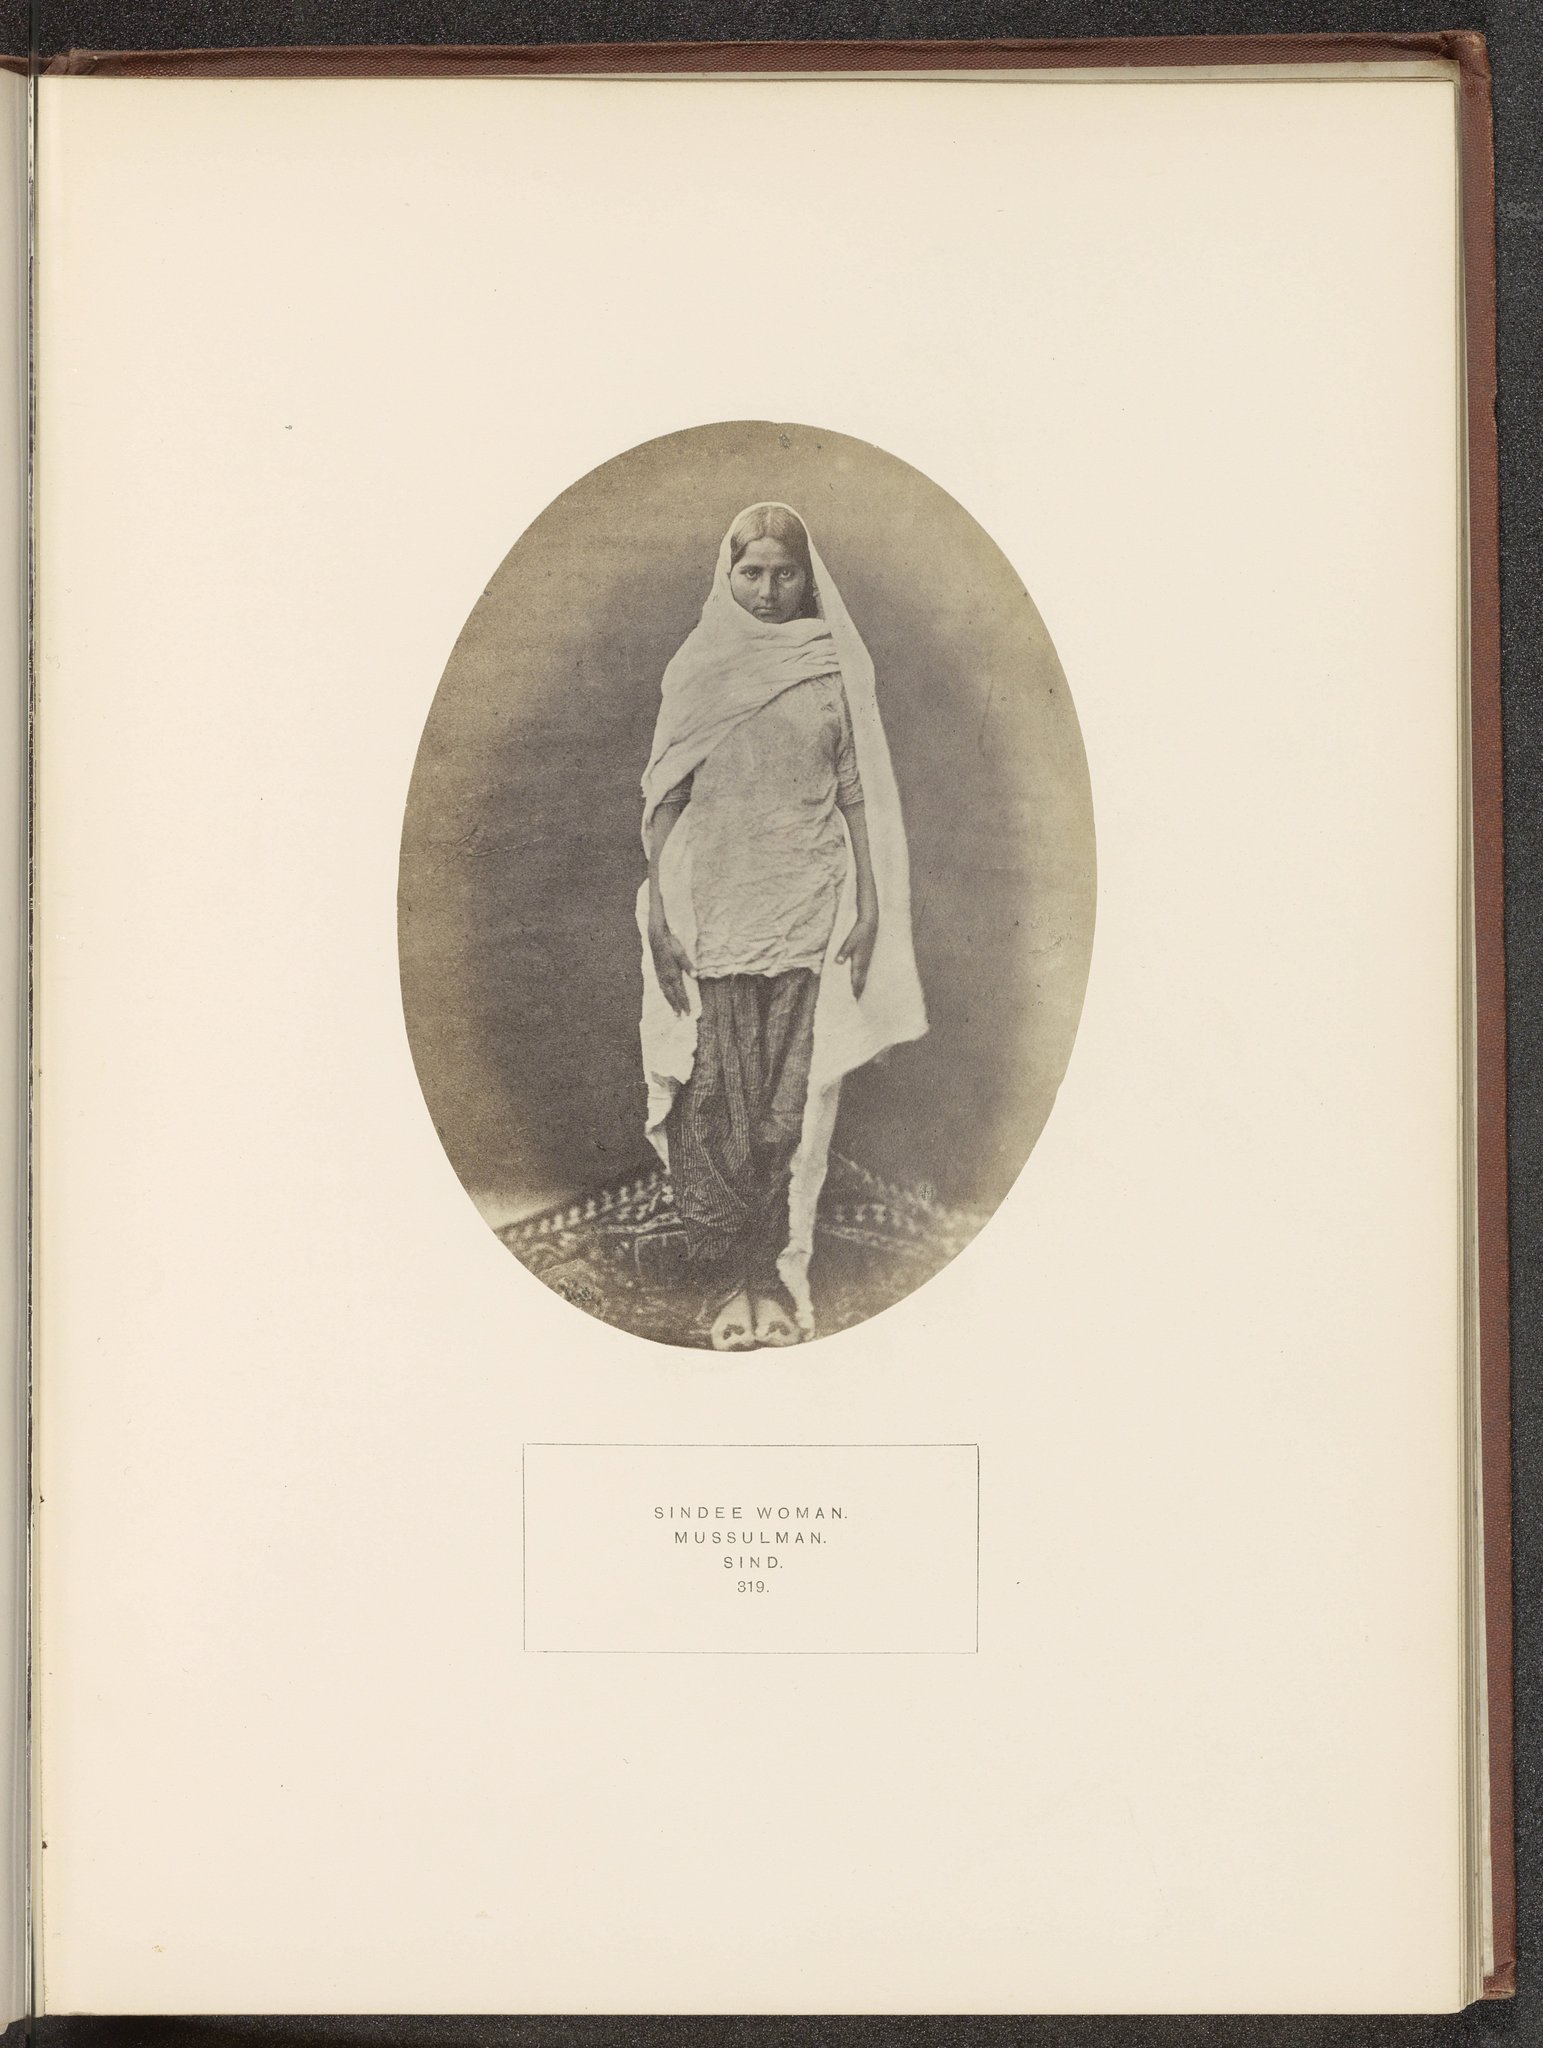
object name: photograph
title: Portrait of an unknown woman from a Sindhi tribe in Sindh, Pakistan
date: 1862-1872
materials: photographic support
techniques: albumen print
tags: head-gear (with name), human races; peoples; nationalities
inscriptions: inscription: ‘SINDEE WOMAN./ MUSSULMAN./ SIND.’, number: ‘319.’